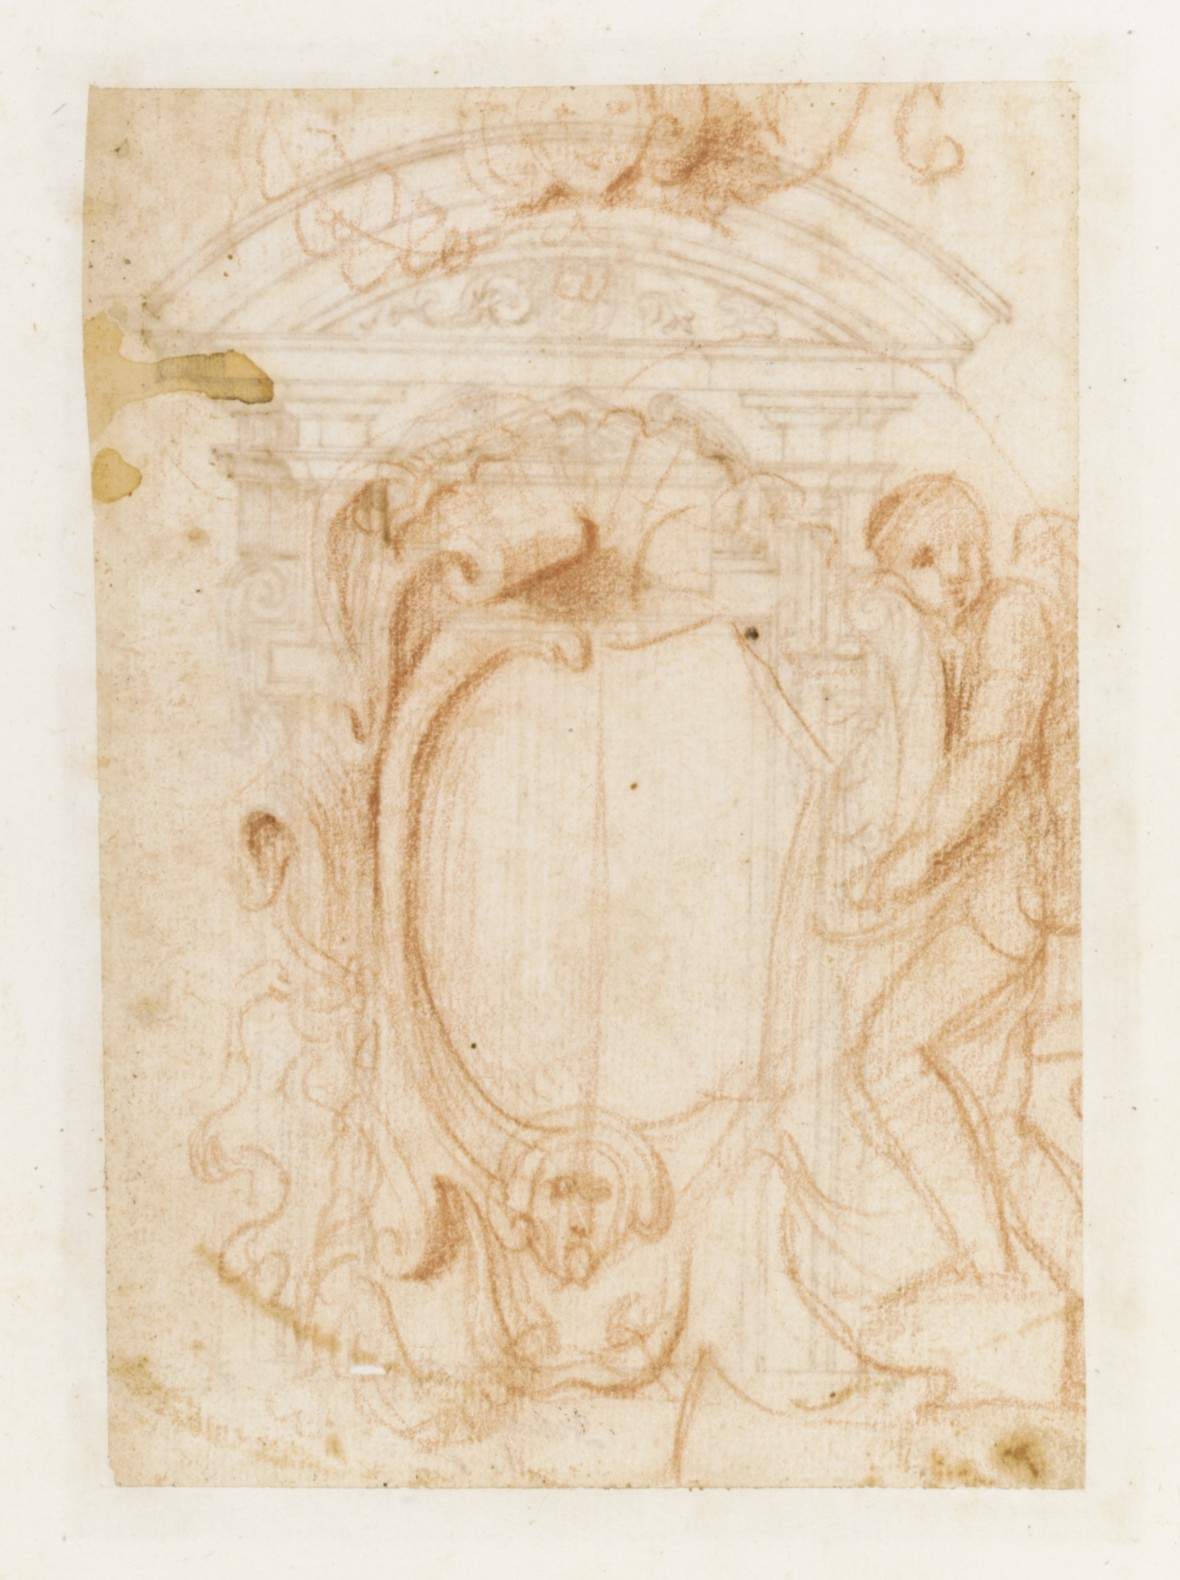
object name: ornament architecture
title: Album Containing Architectural, Ornament, and Figure Drawings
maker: giovanni battista mola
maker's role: artist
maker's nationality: italian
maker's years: 1585-1665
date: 1630-1631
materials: chalk, graphite, ink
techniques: incising, pen, wash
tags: architecture,men